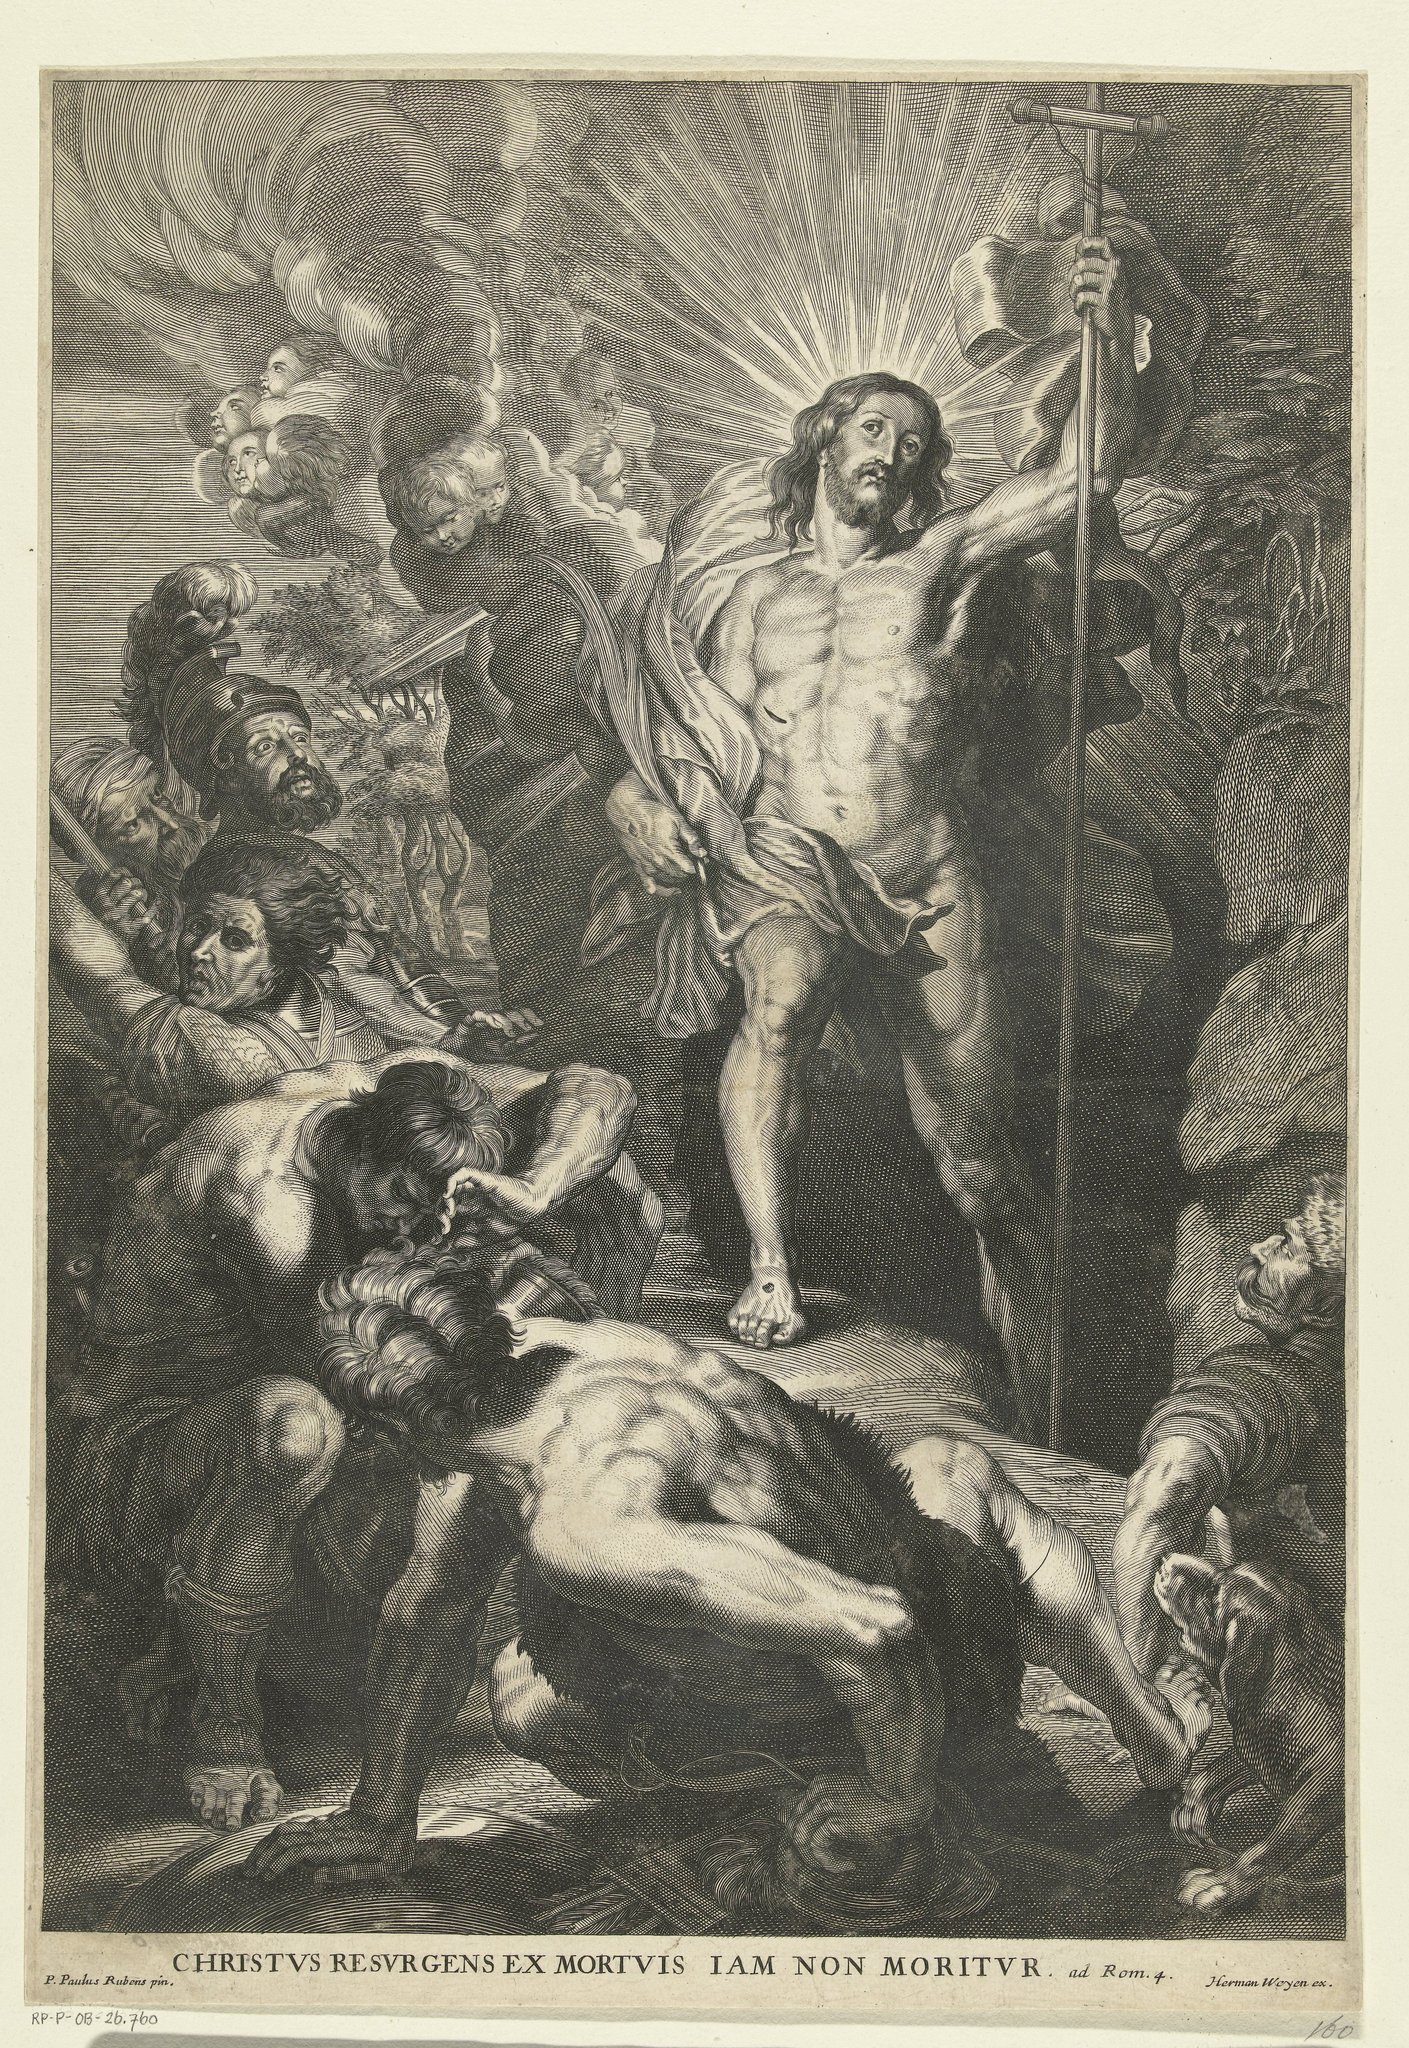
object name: print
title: Verrijzenis van Christus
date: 1596-1709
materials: paper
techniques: engraving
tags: christ stepping out of the tomb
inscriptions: collector's mark: Lugt 240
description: Christus staat op uit zijn graf en de bewakers reageren geschrokken op zijn verschijning. Onder de voorstelling staat een citaat uit Romeinen 4.